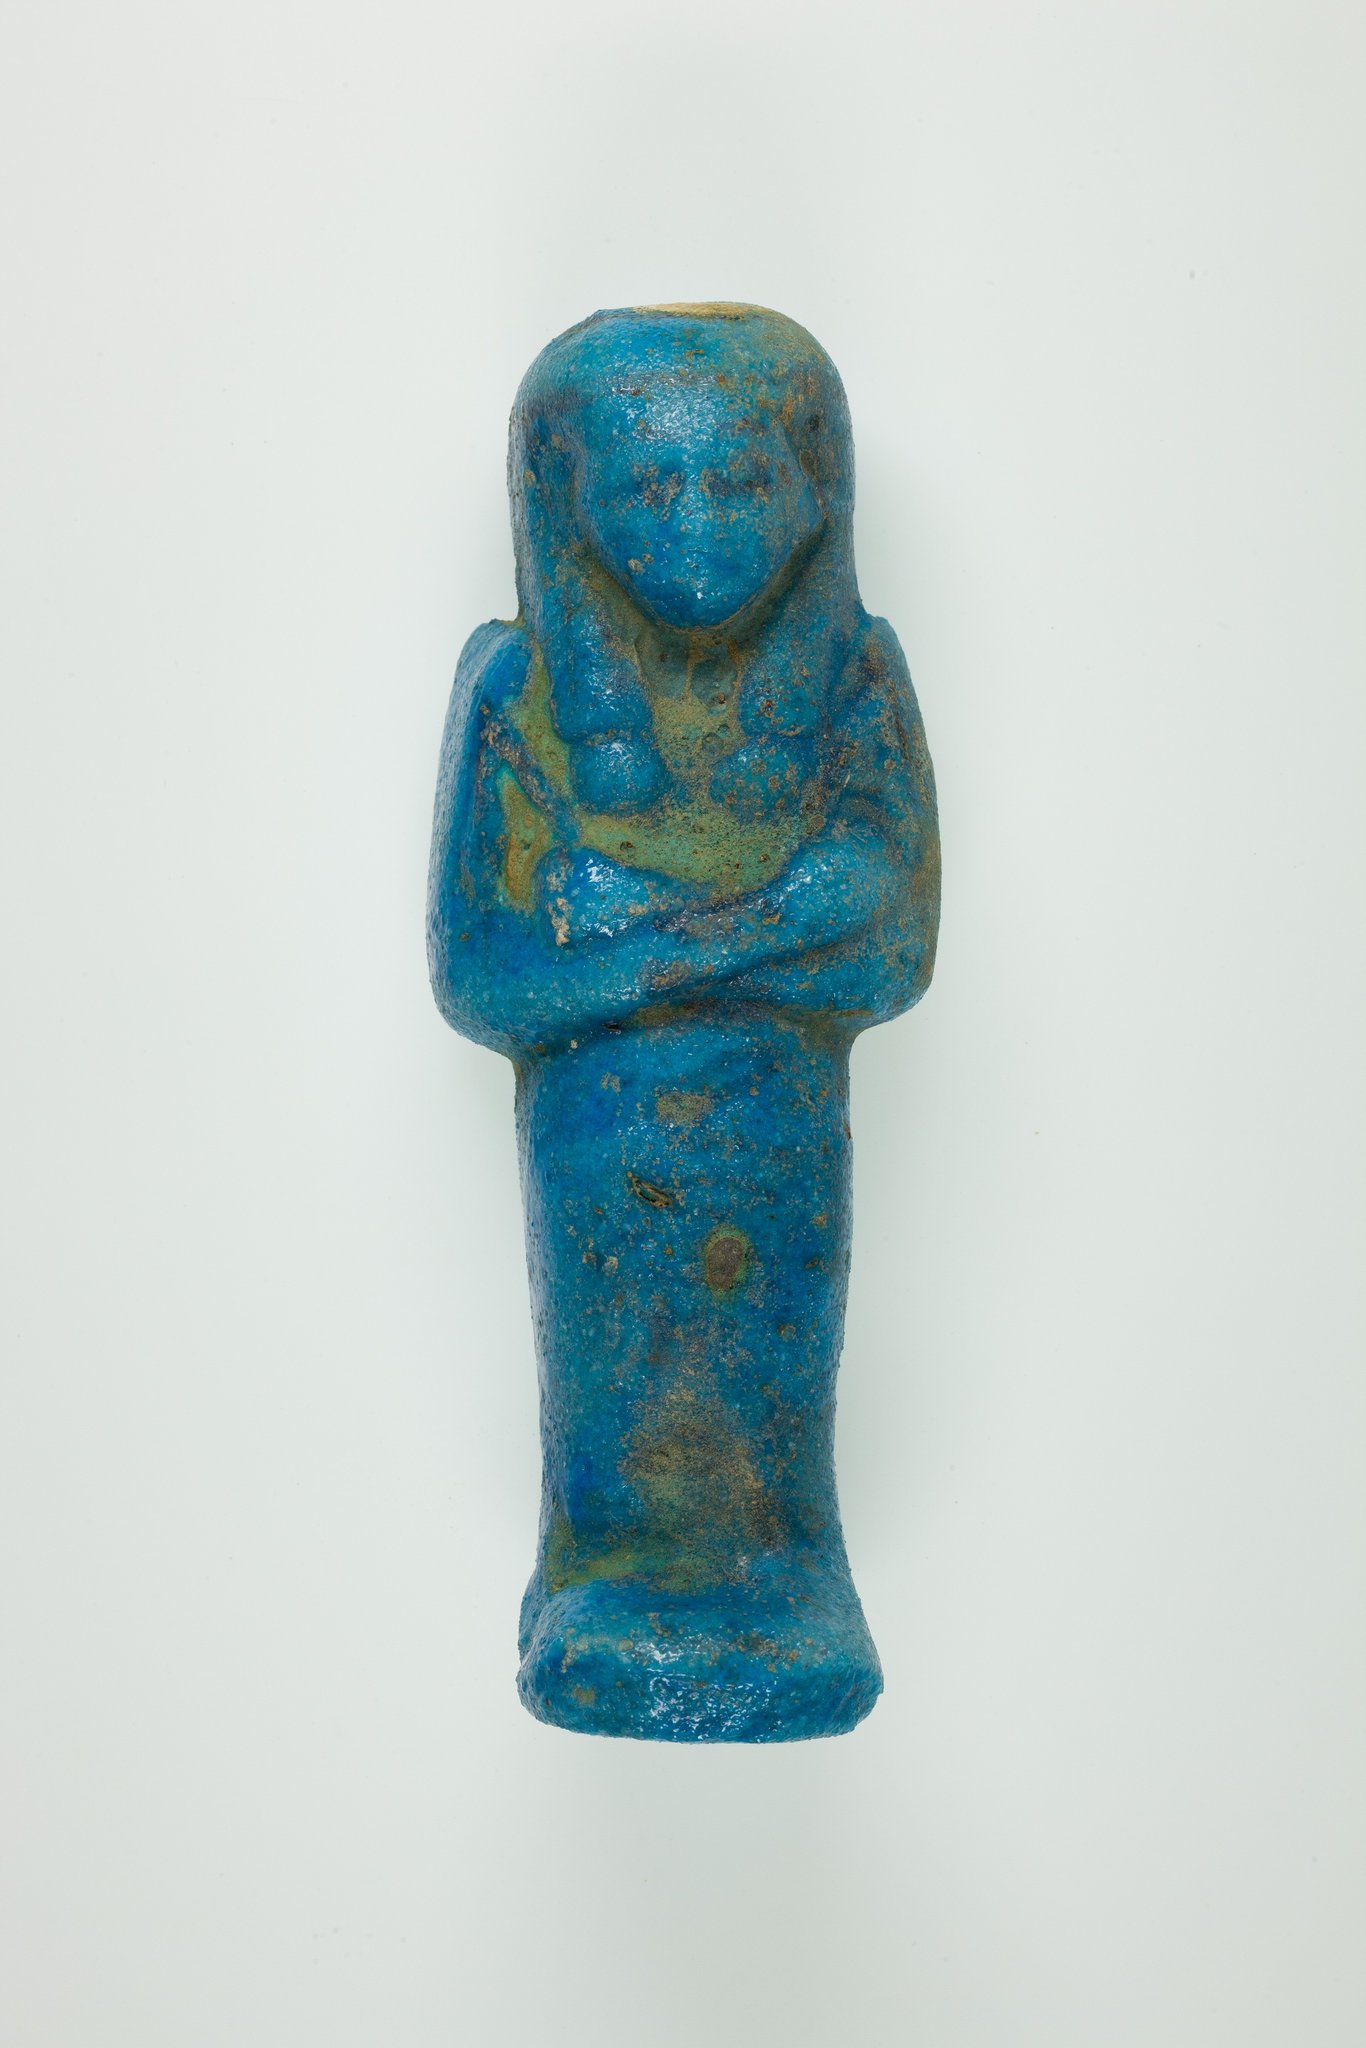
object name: worker shabti, henettawy c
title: Worker Shabti of Henettawy (C), Daughter of Isetemkheb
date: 990-970 BCE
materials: faience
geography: egypt